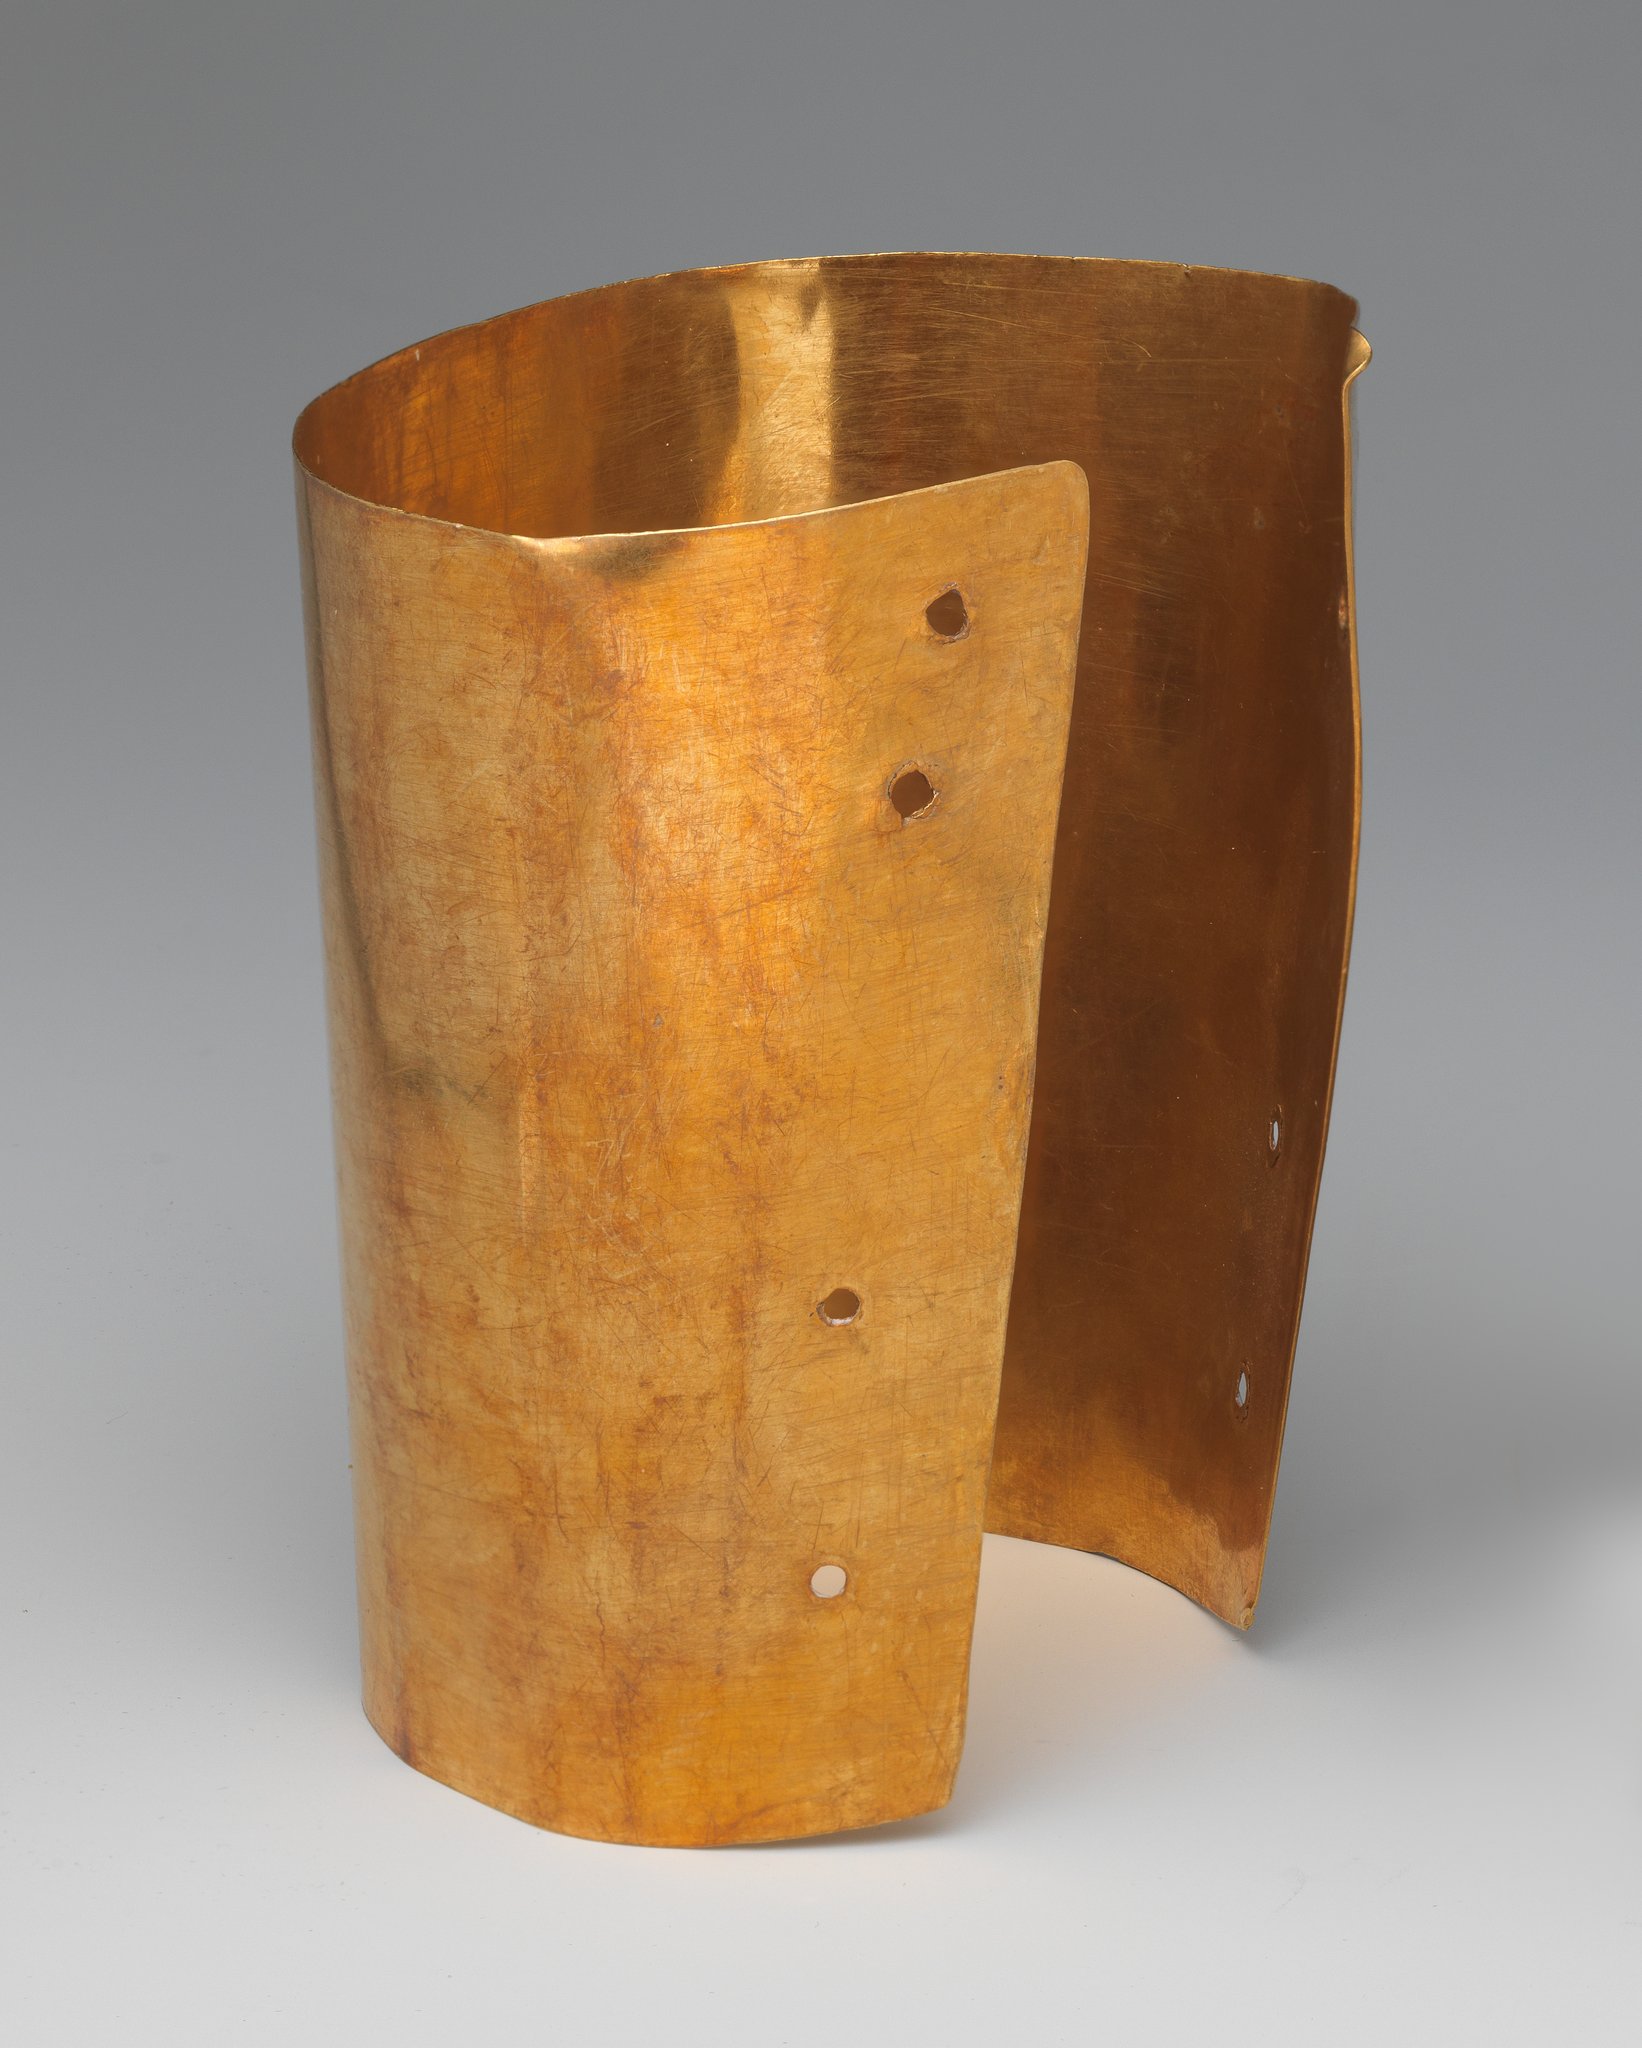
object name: arm band, one of a pair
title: Cuff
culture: conte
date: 501-1200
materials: gold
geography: panama